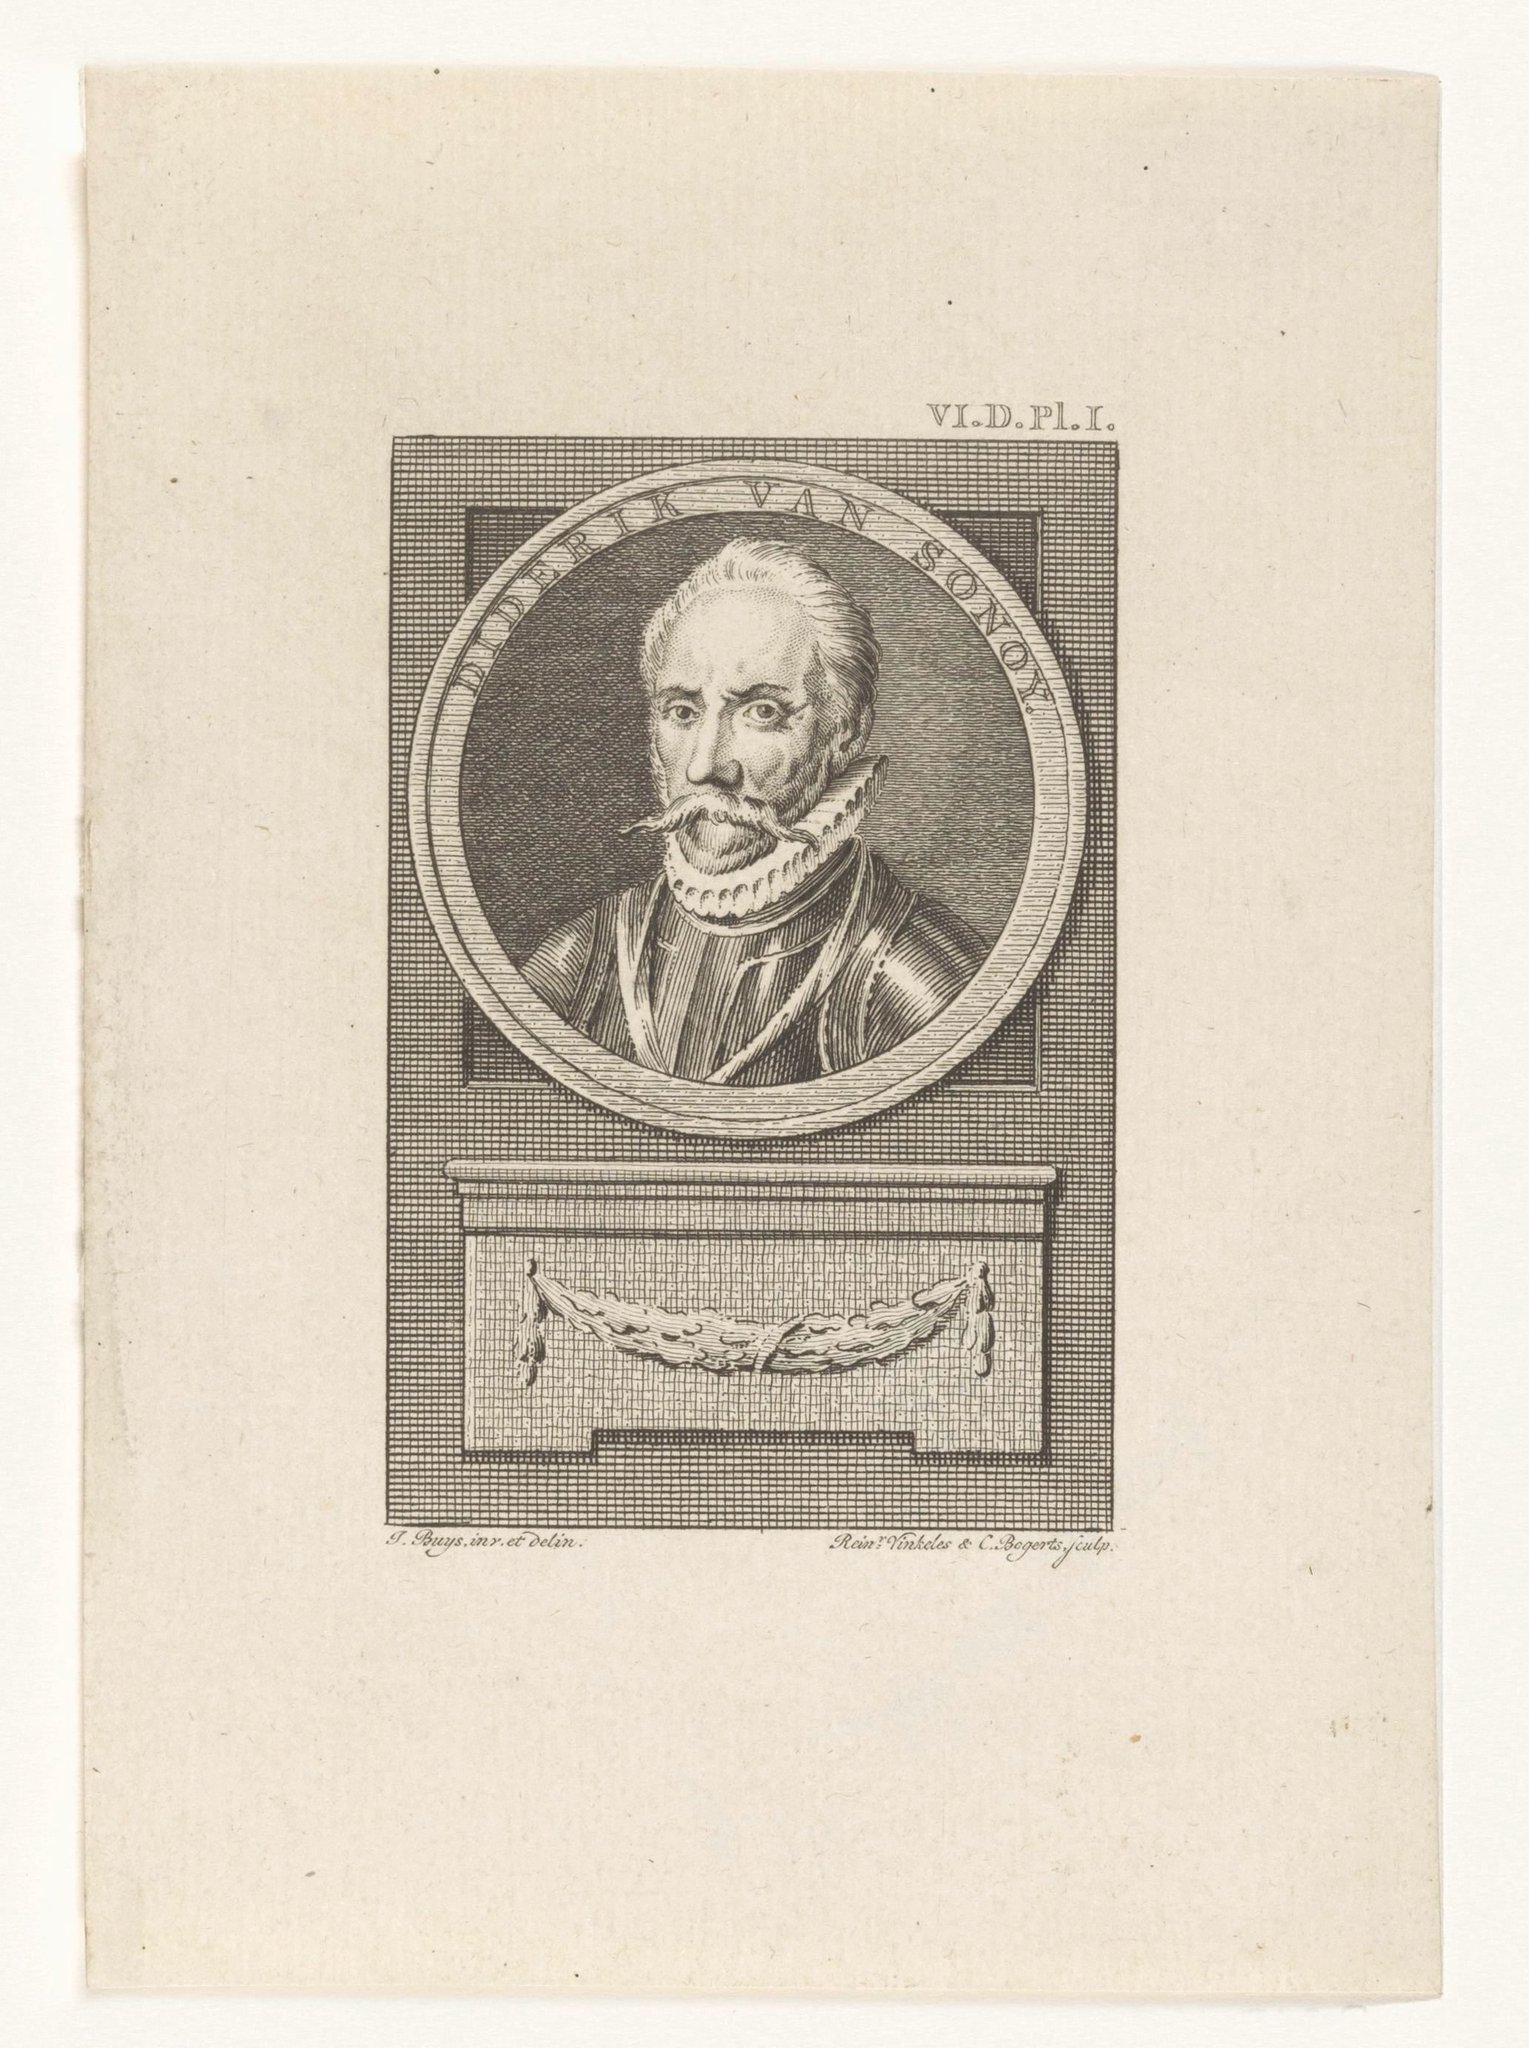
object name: print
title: Portret van Diederik van Sonoy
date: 1785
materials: paper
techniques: engraving, etching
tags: kalkar, historical persons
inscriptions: collector's mark: Lugt 2228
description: Prent gebruikt in: Fokke, Jan. Geschiedenissen der Vereenigde Nederlanden. Voor de vaderlandsche jeugd. 25 delen. Amsterdam: Johannes Allart, 1783-1795, dl. 6 (1785), na p. 68.